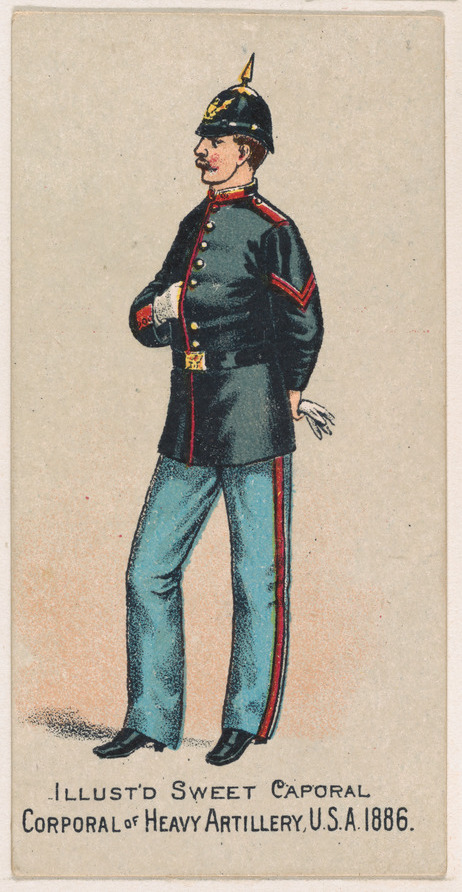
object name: print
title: Corporal of Heavy Artillery, United States Army, 1886, from the Military Series (N224) issued by Kinney Tobacco Company to promote Sweet Caporal Cigarettes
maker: kinney brothers tobacco company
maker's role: publisher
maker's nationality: american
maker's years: 1869-2011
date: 1888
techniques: color lithograph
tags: army,military,men,profiles